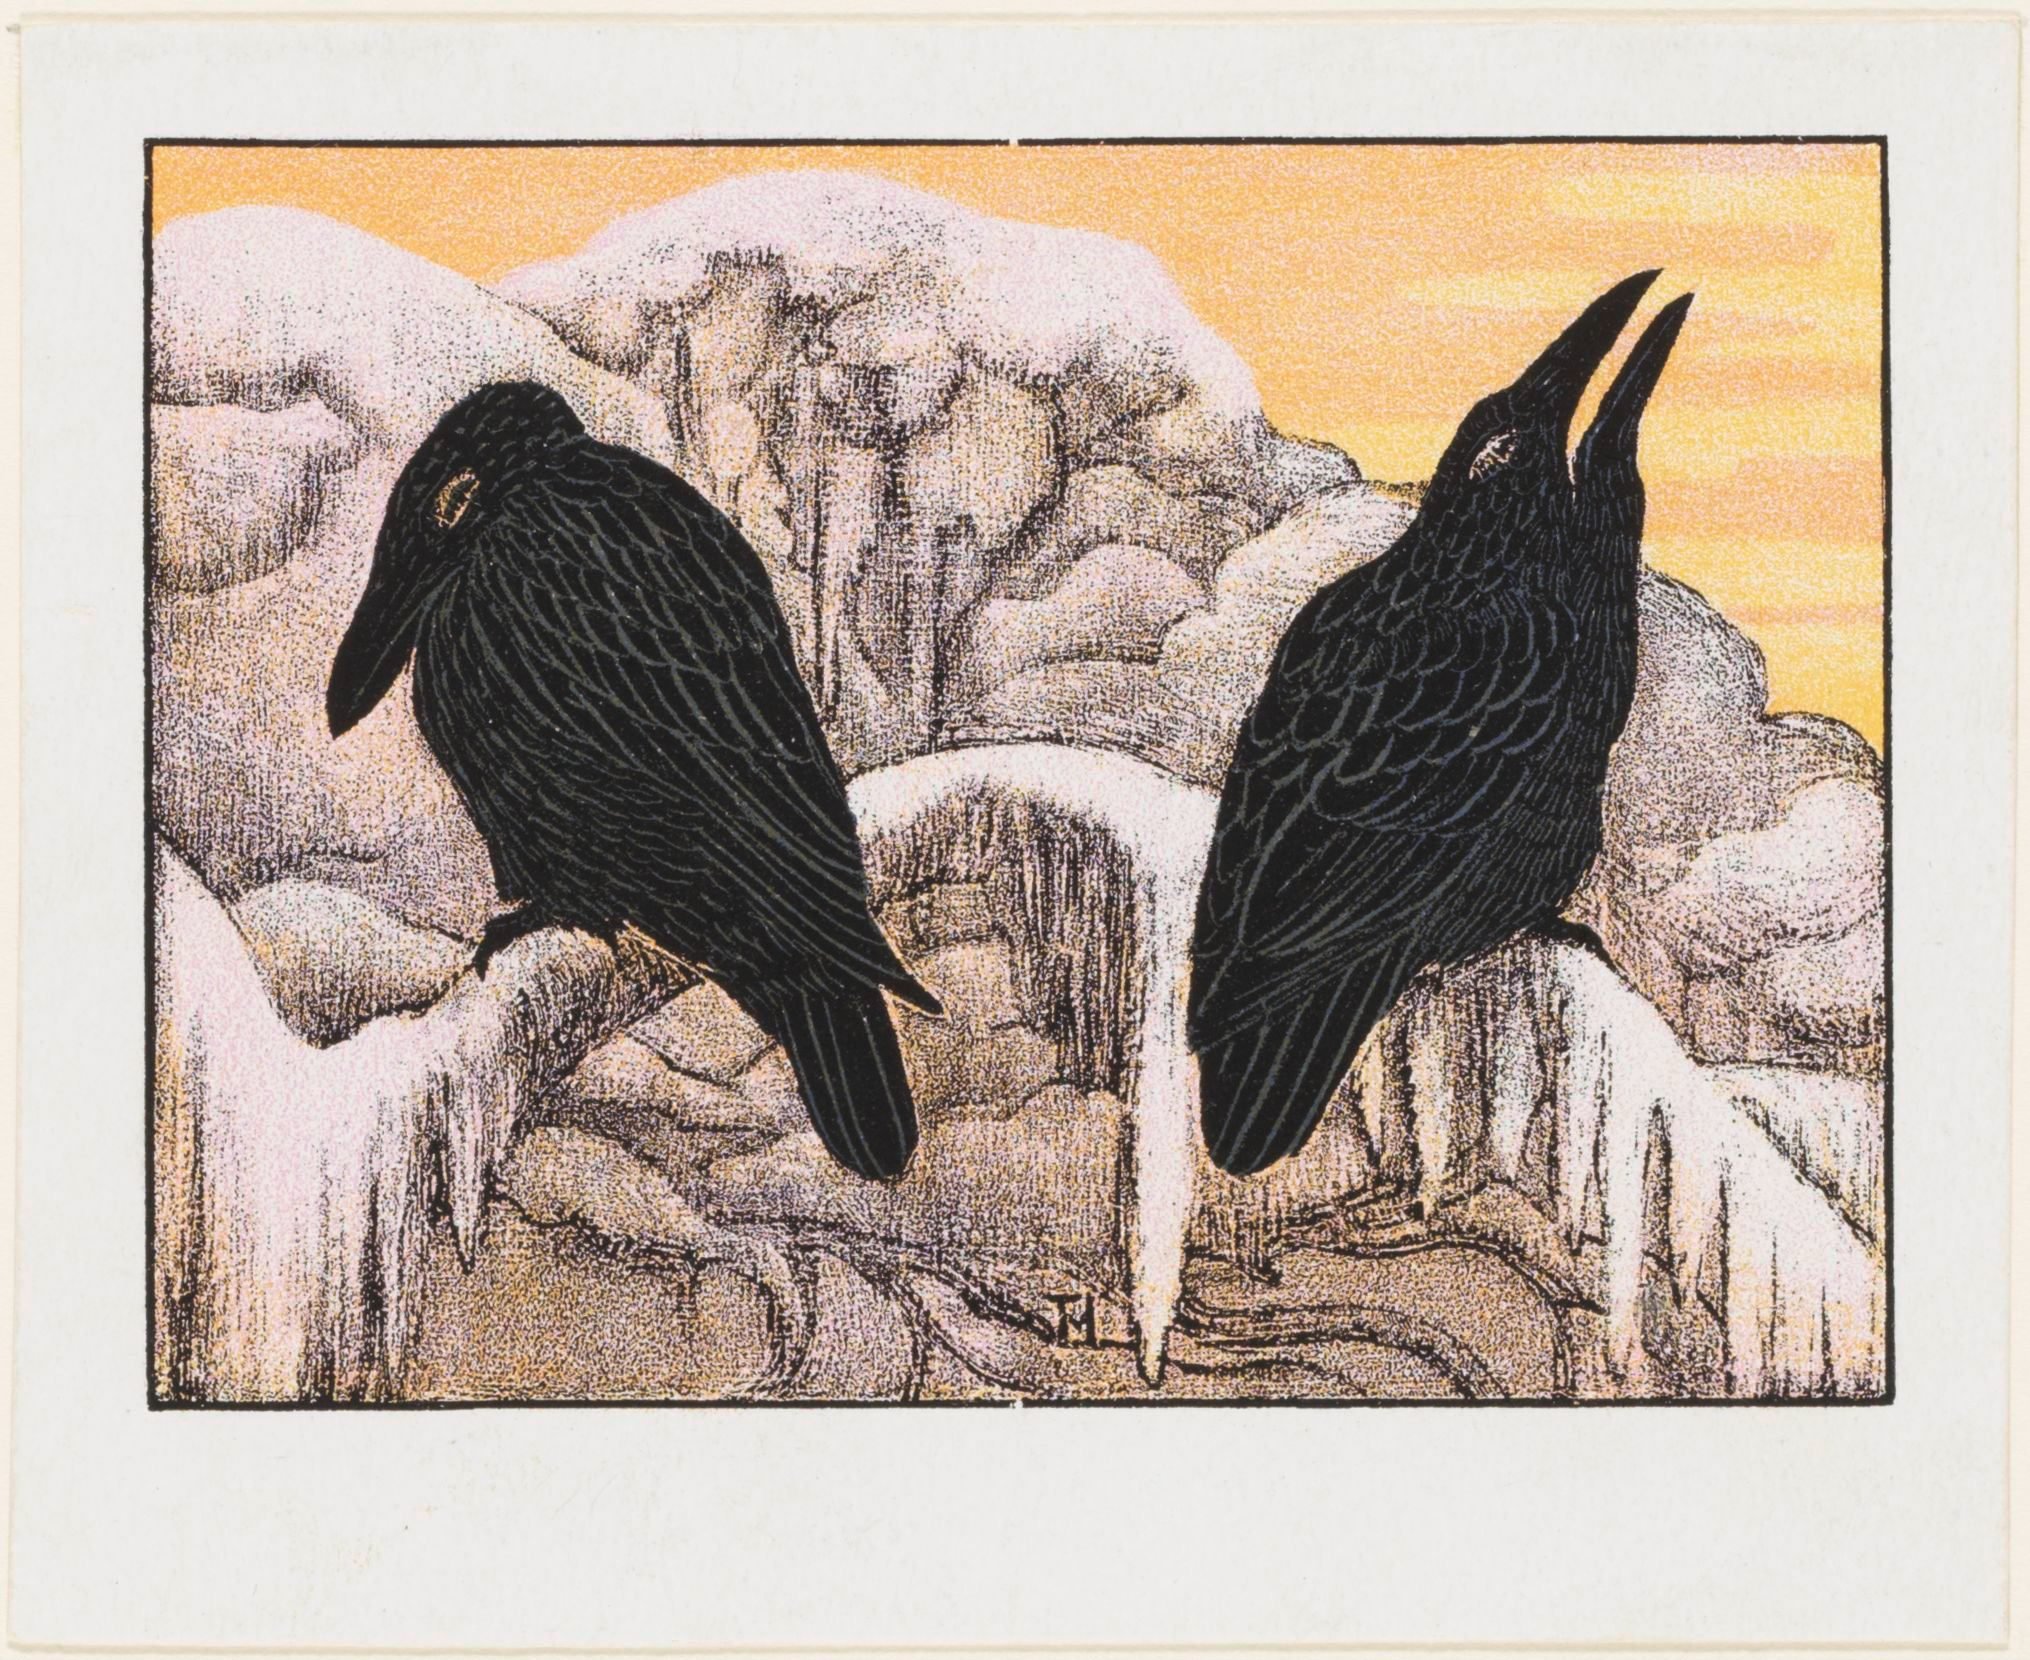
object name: print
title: Omslag zakkalender voor Van Houten Cacao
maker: theo van hoytema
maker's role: draughtsman, painter, print maker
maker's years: 1863-1917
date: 1903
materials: paper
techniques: lithograph, letterpress printing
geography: weesp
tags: song-birds: jackdaw, song-birds: crow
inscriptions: collector's mark: Lugt 2233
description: Een kraai en een kauw op een besneeuwde tak.